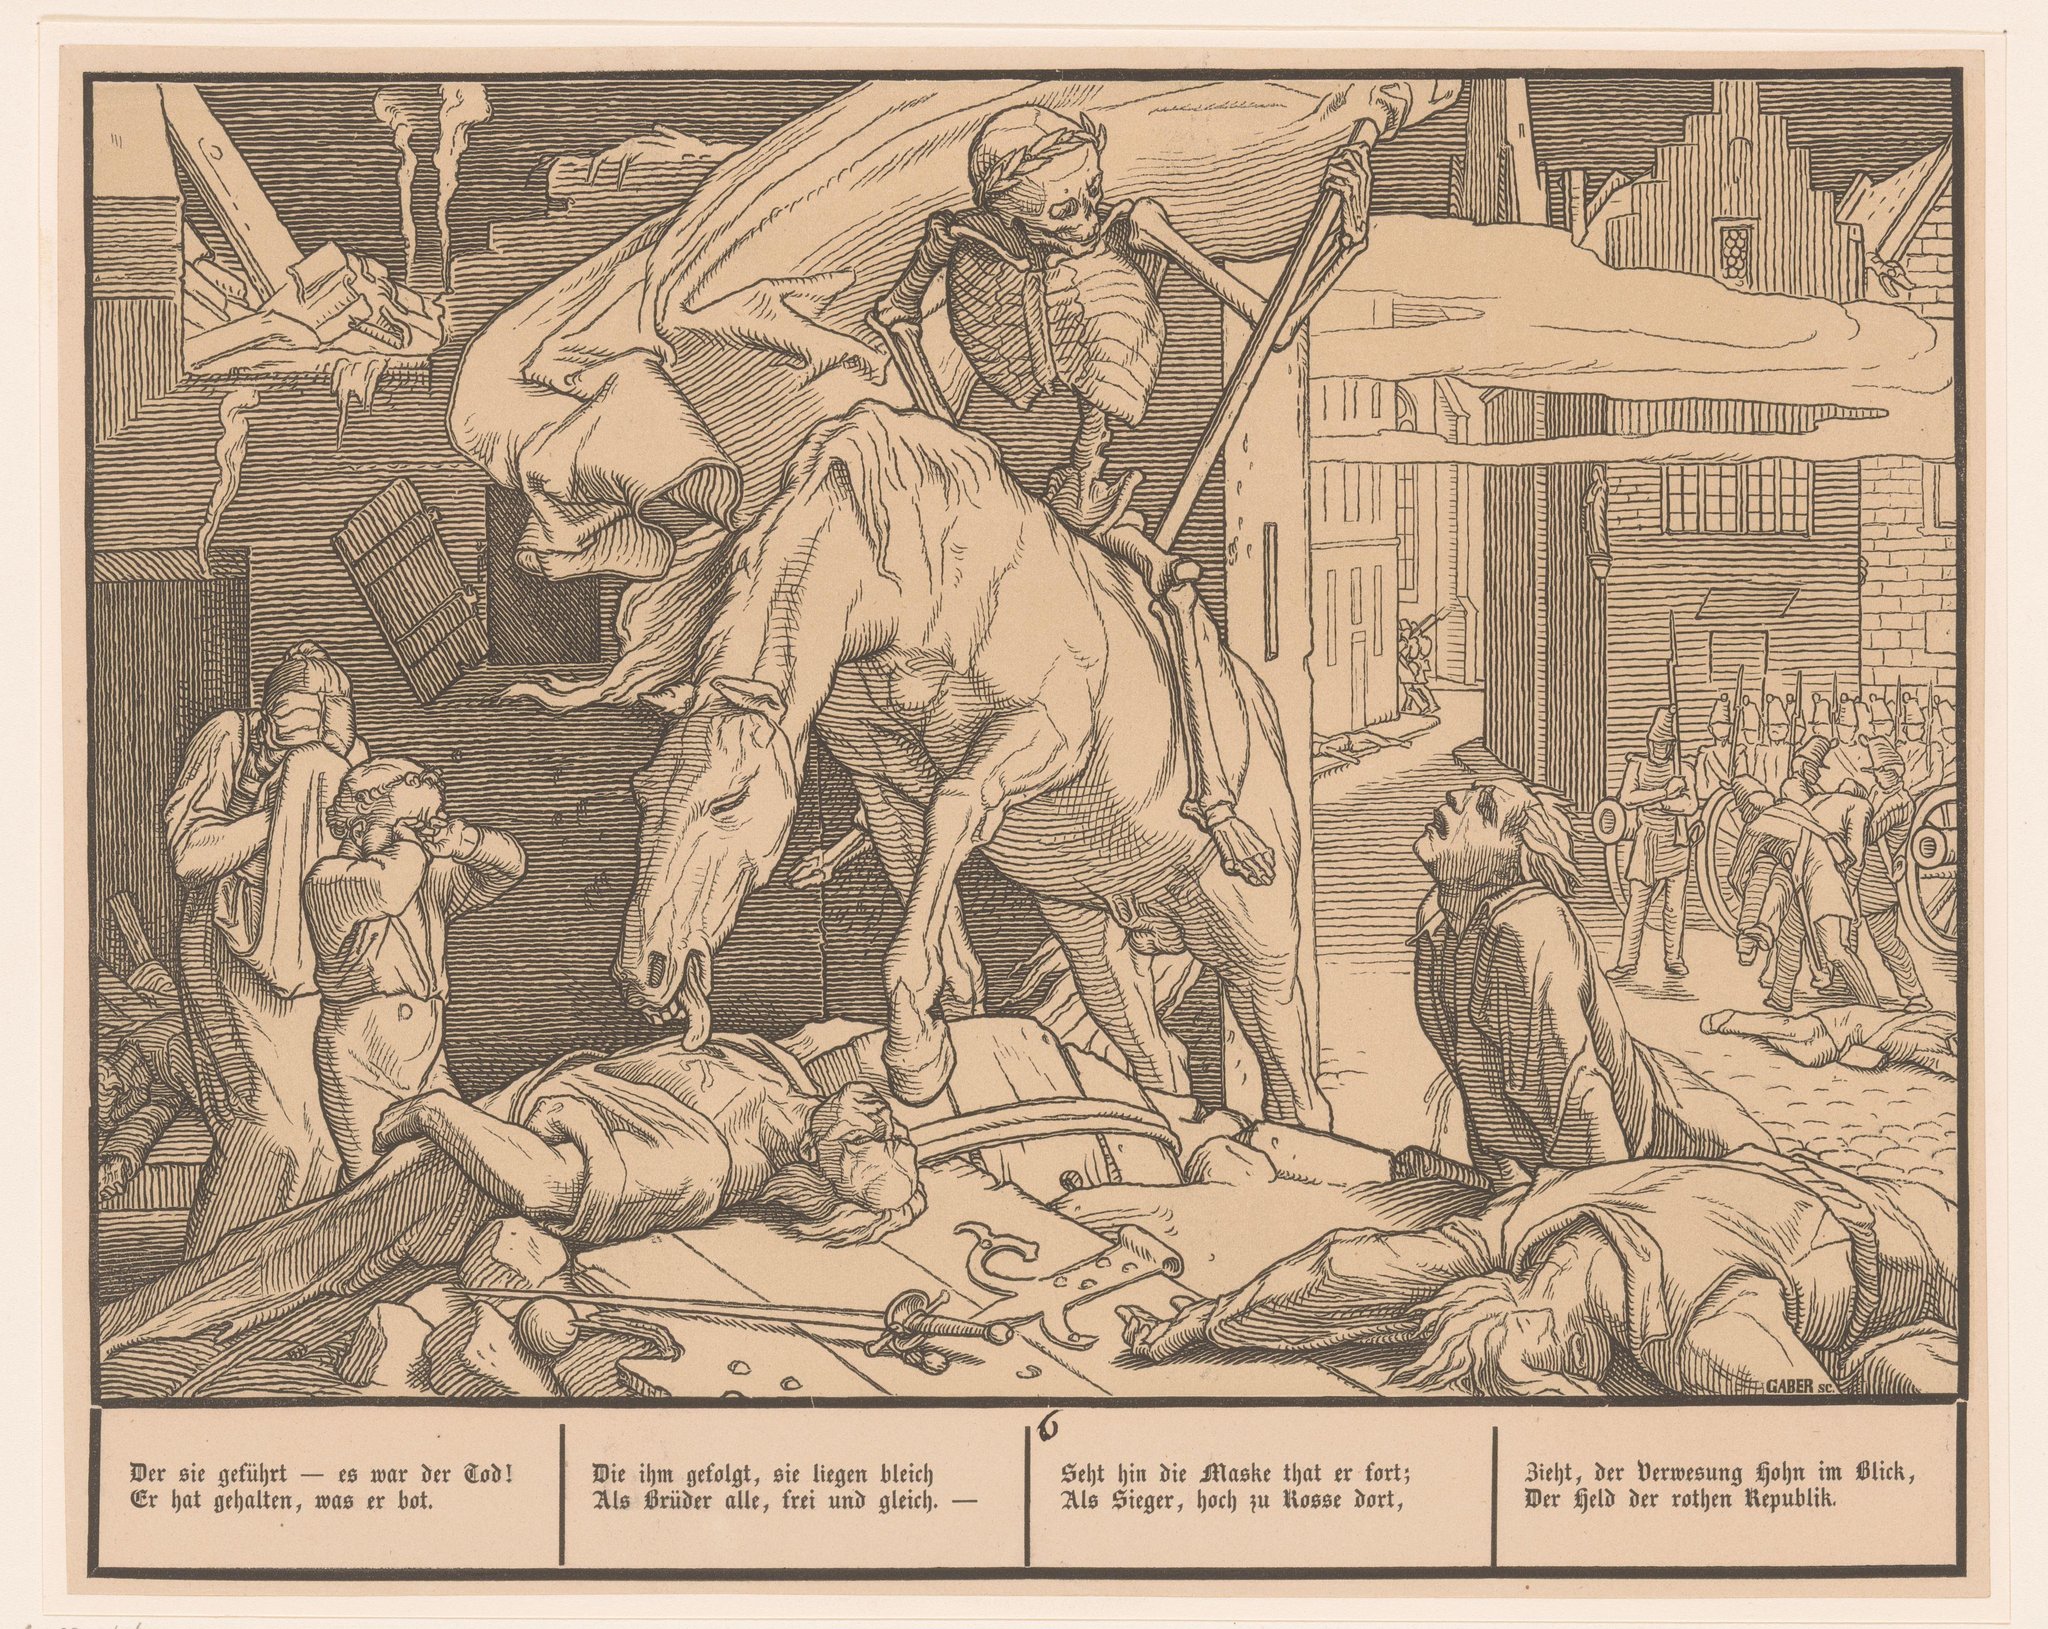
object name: print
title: Nieuwe Dodendans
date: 1848-1849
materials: paper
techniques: woodcut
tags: dance of death; death together with one or more human beings, revolution, revolt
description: Allegorie op de revolutie in de Duitse landen van 1848: "Ein Totentanz aus dem Jahre 1848", Volksuitgave van Augustus.